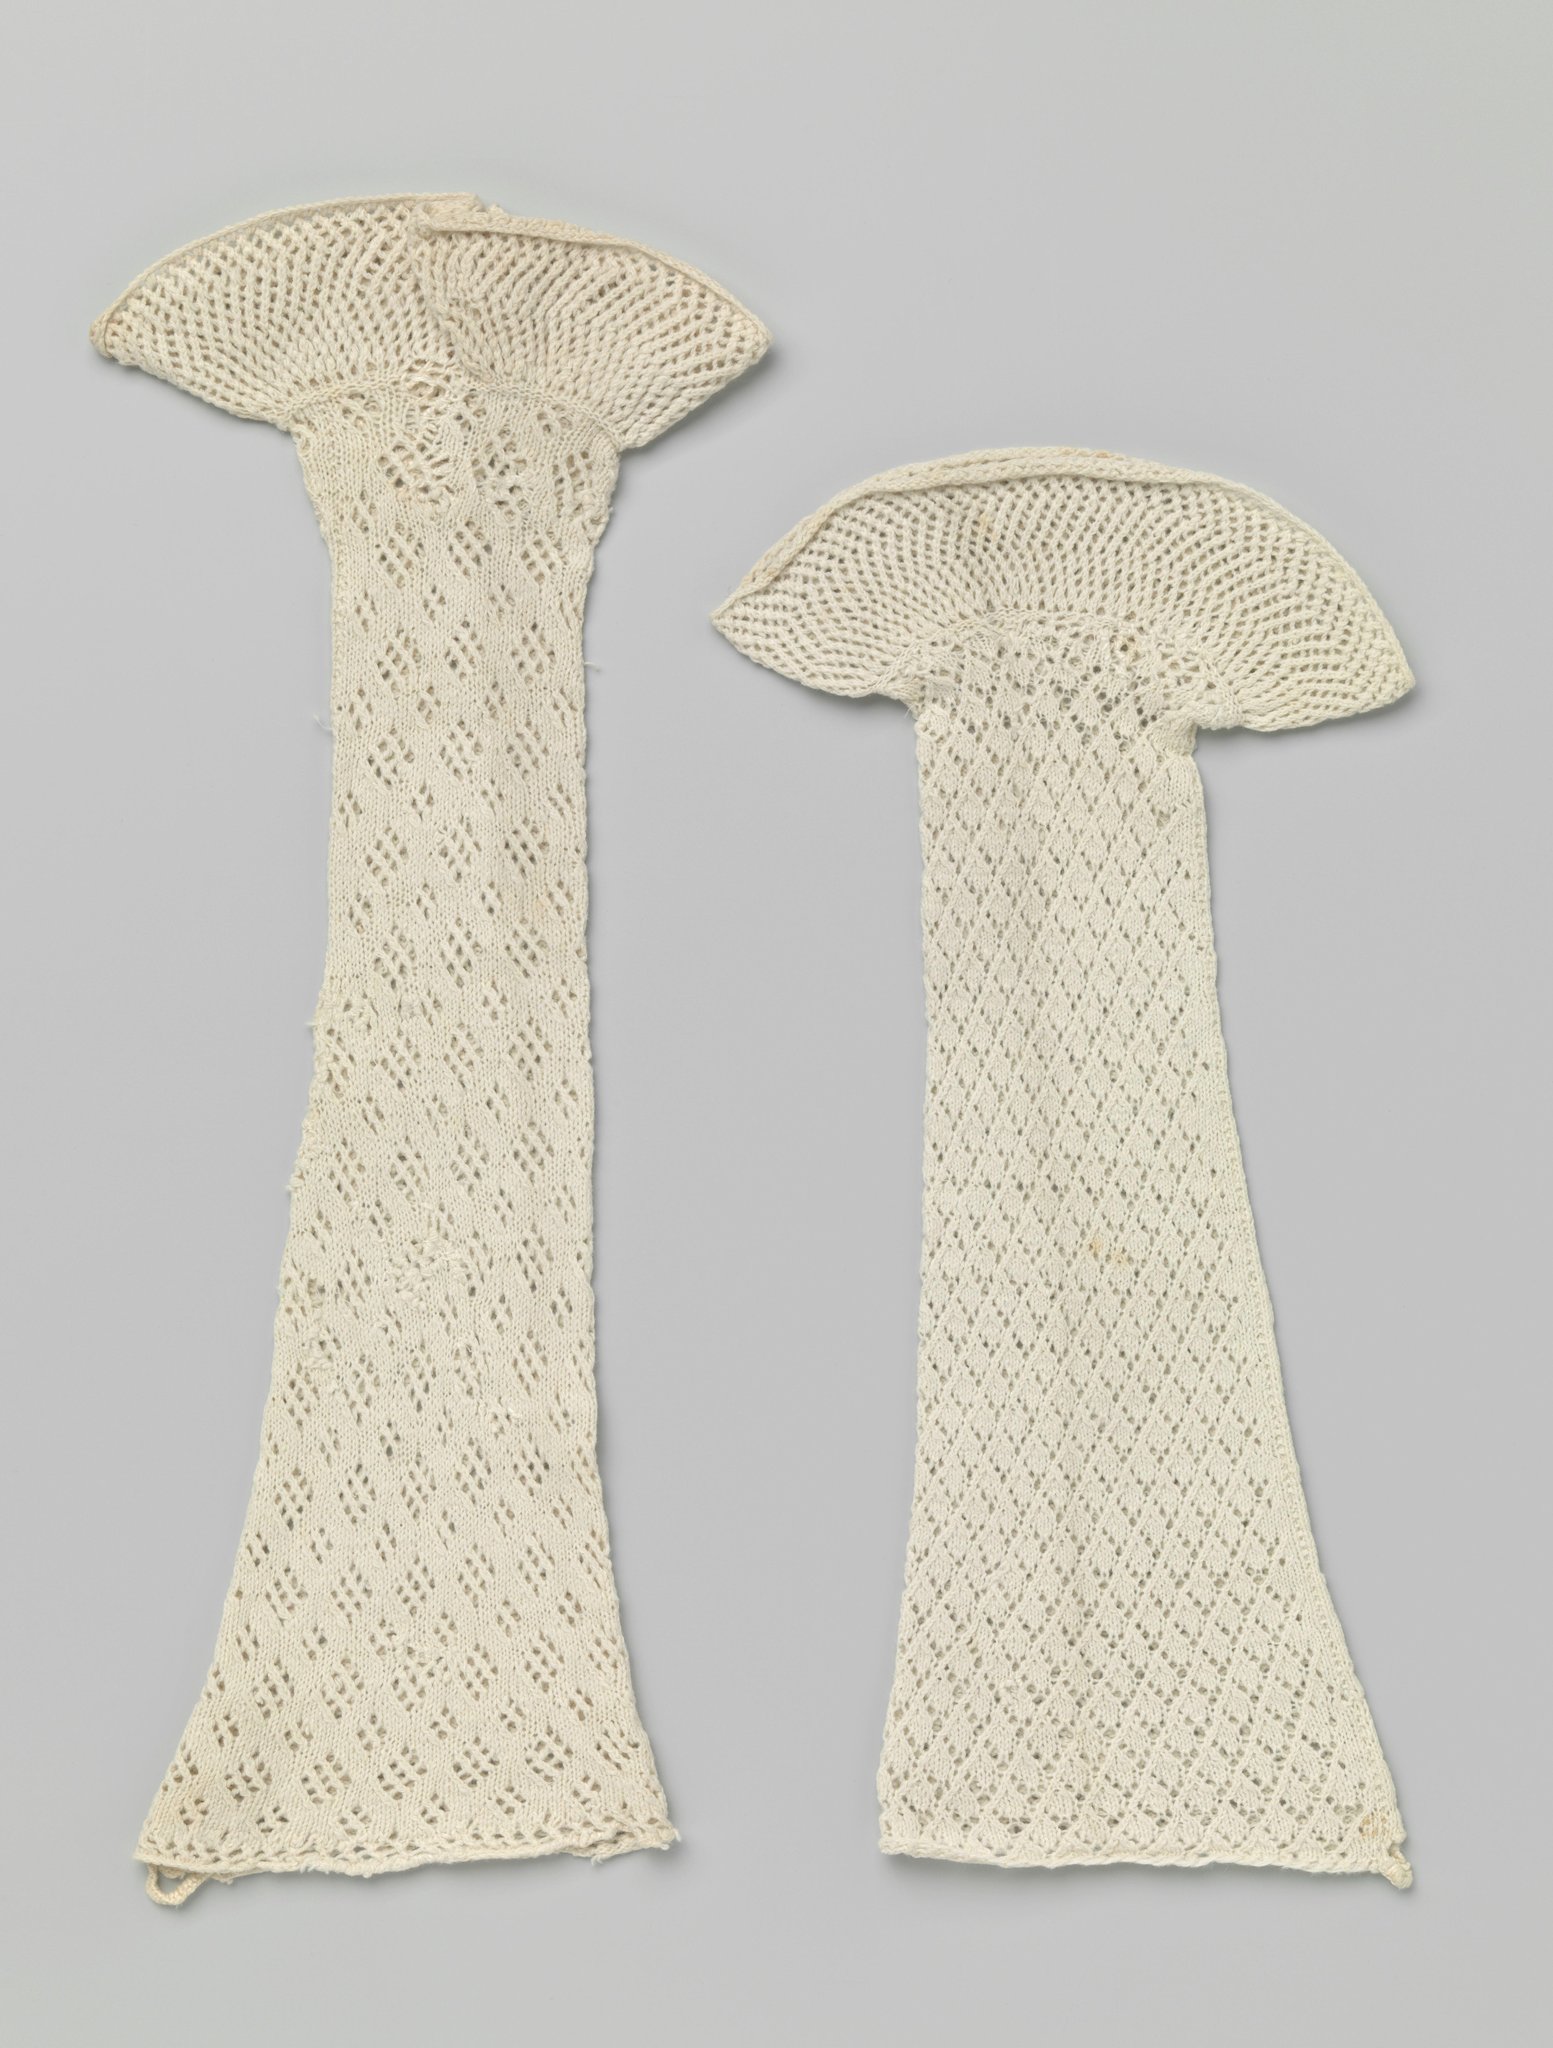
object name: womenswear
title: Mitaine van witte gebreide katoen in ajour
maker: Anonymous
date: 1850-1945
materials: cotton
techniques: embroidery, knitting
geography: europe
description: Mitaine van witte gebreide katoen in ajour, met een ruitpatroon en met een klokkende over de hand vallende strook. Onleesbaar gemerkt.